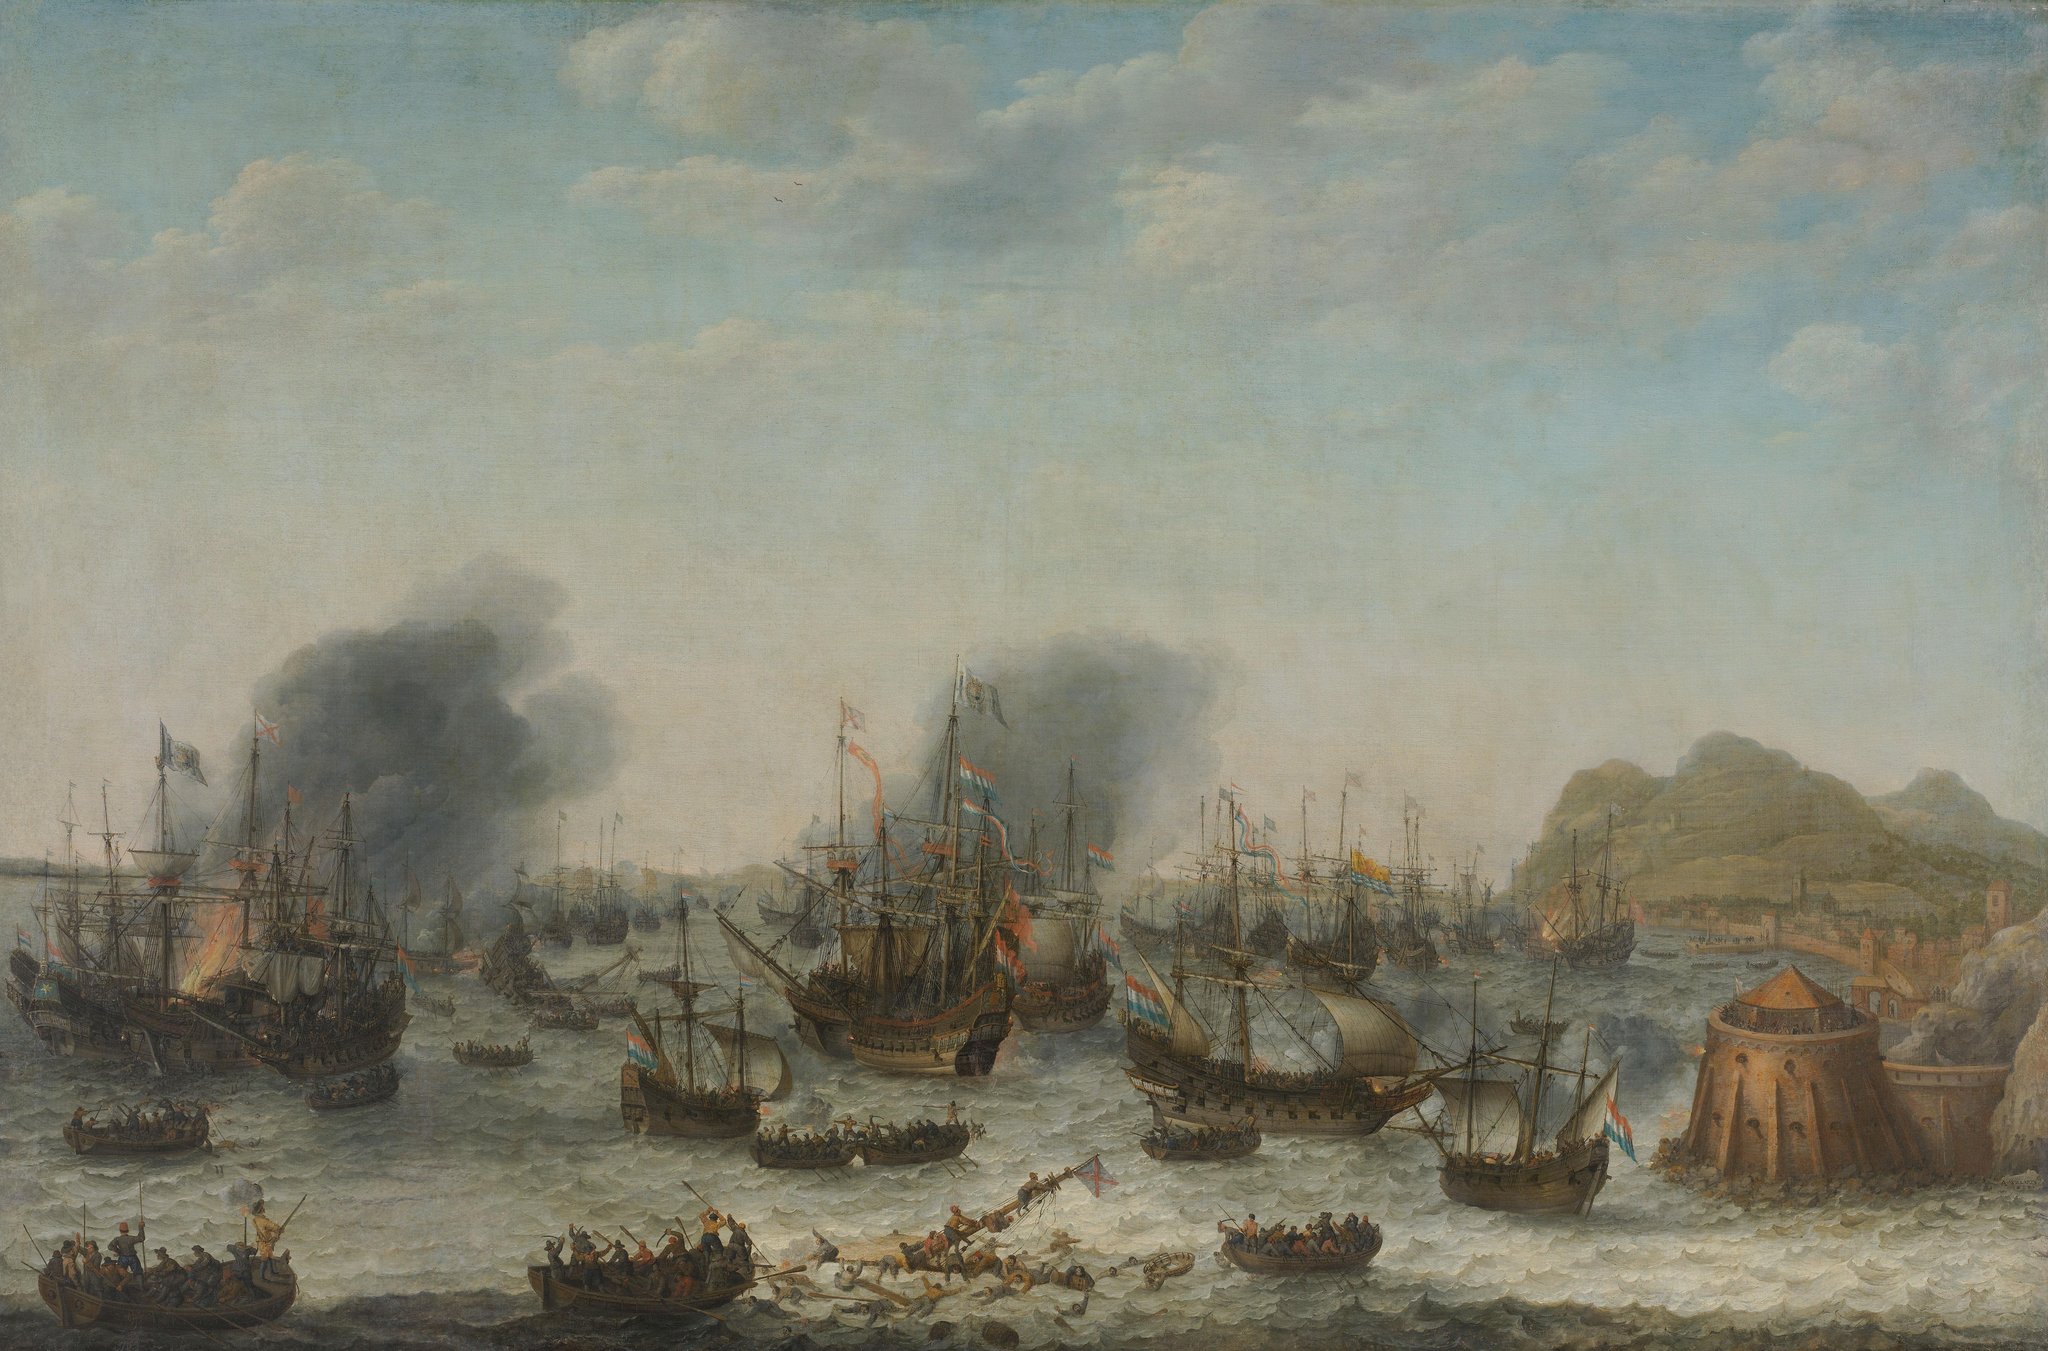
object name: painting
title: The Defeat of the Spanish at Gibraltar by a Dutch Fleet under the Command of Admiral Jacob van Heemskerck, 25 April 1607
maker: adam willaerts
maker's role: painter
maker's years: 1577-1664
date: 1639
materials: canvas, oil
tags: amsterdam, jacob van heemskerck, battle (+ sailing-ships)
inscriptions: signature and date, bottom right: ‘A. Willarts 1639’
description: Zeeslag met de overwinning op de Spanjaarden bij Gibraltar door een vloot onder bevel van Jacob van Heemskerck, 25 april 1607. De zee voor de kust is vol met oorlogsschepen die elkaar beschieten, sommige schepen staan in brand. Op de voorgrond tracht de bemanning van een gezonken schip zich in sloepen te redden.